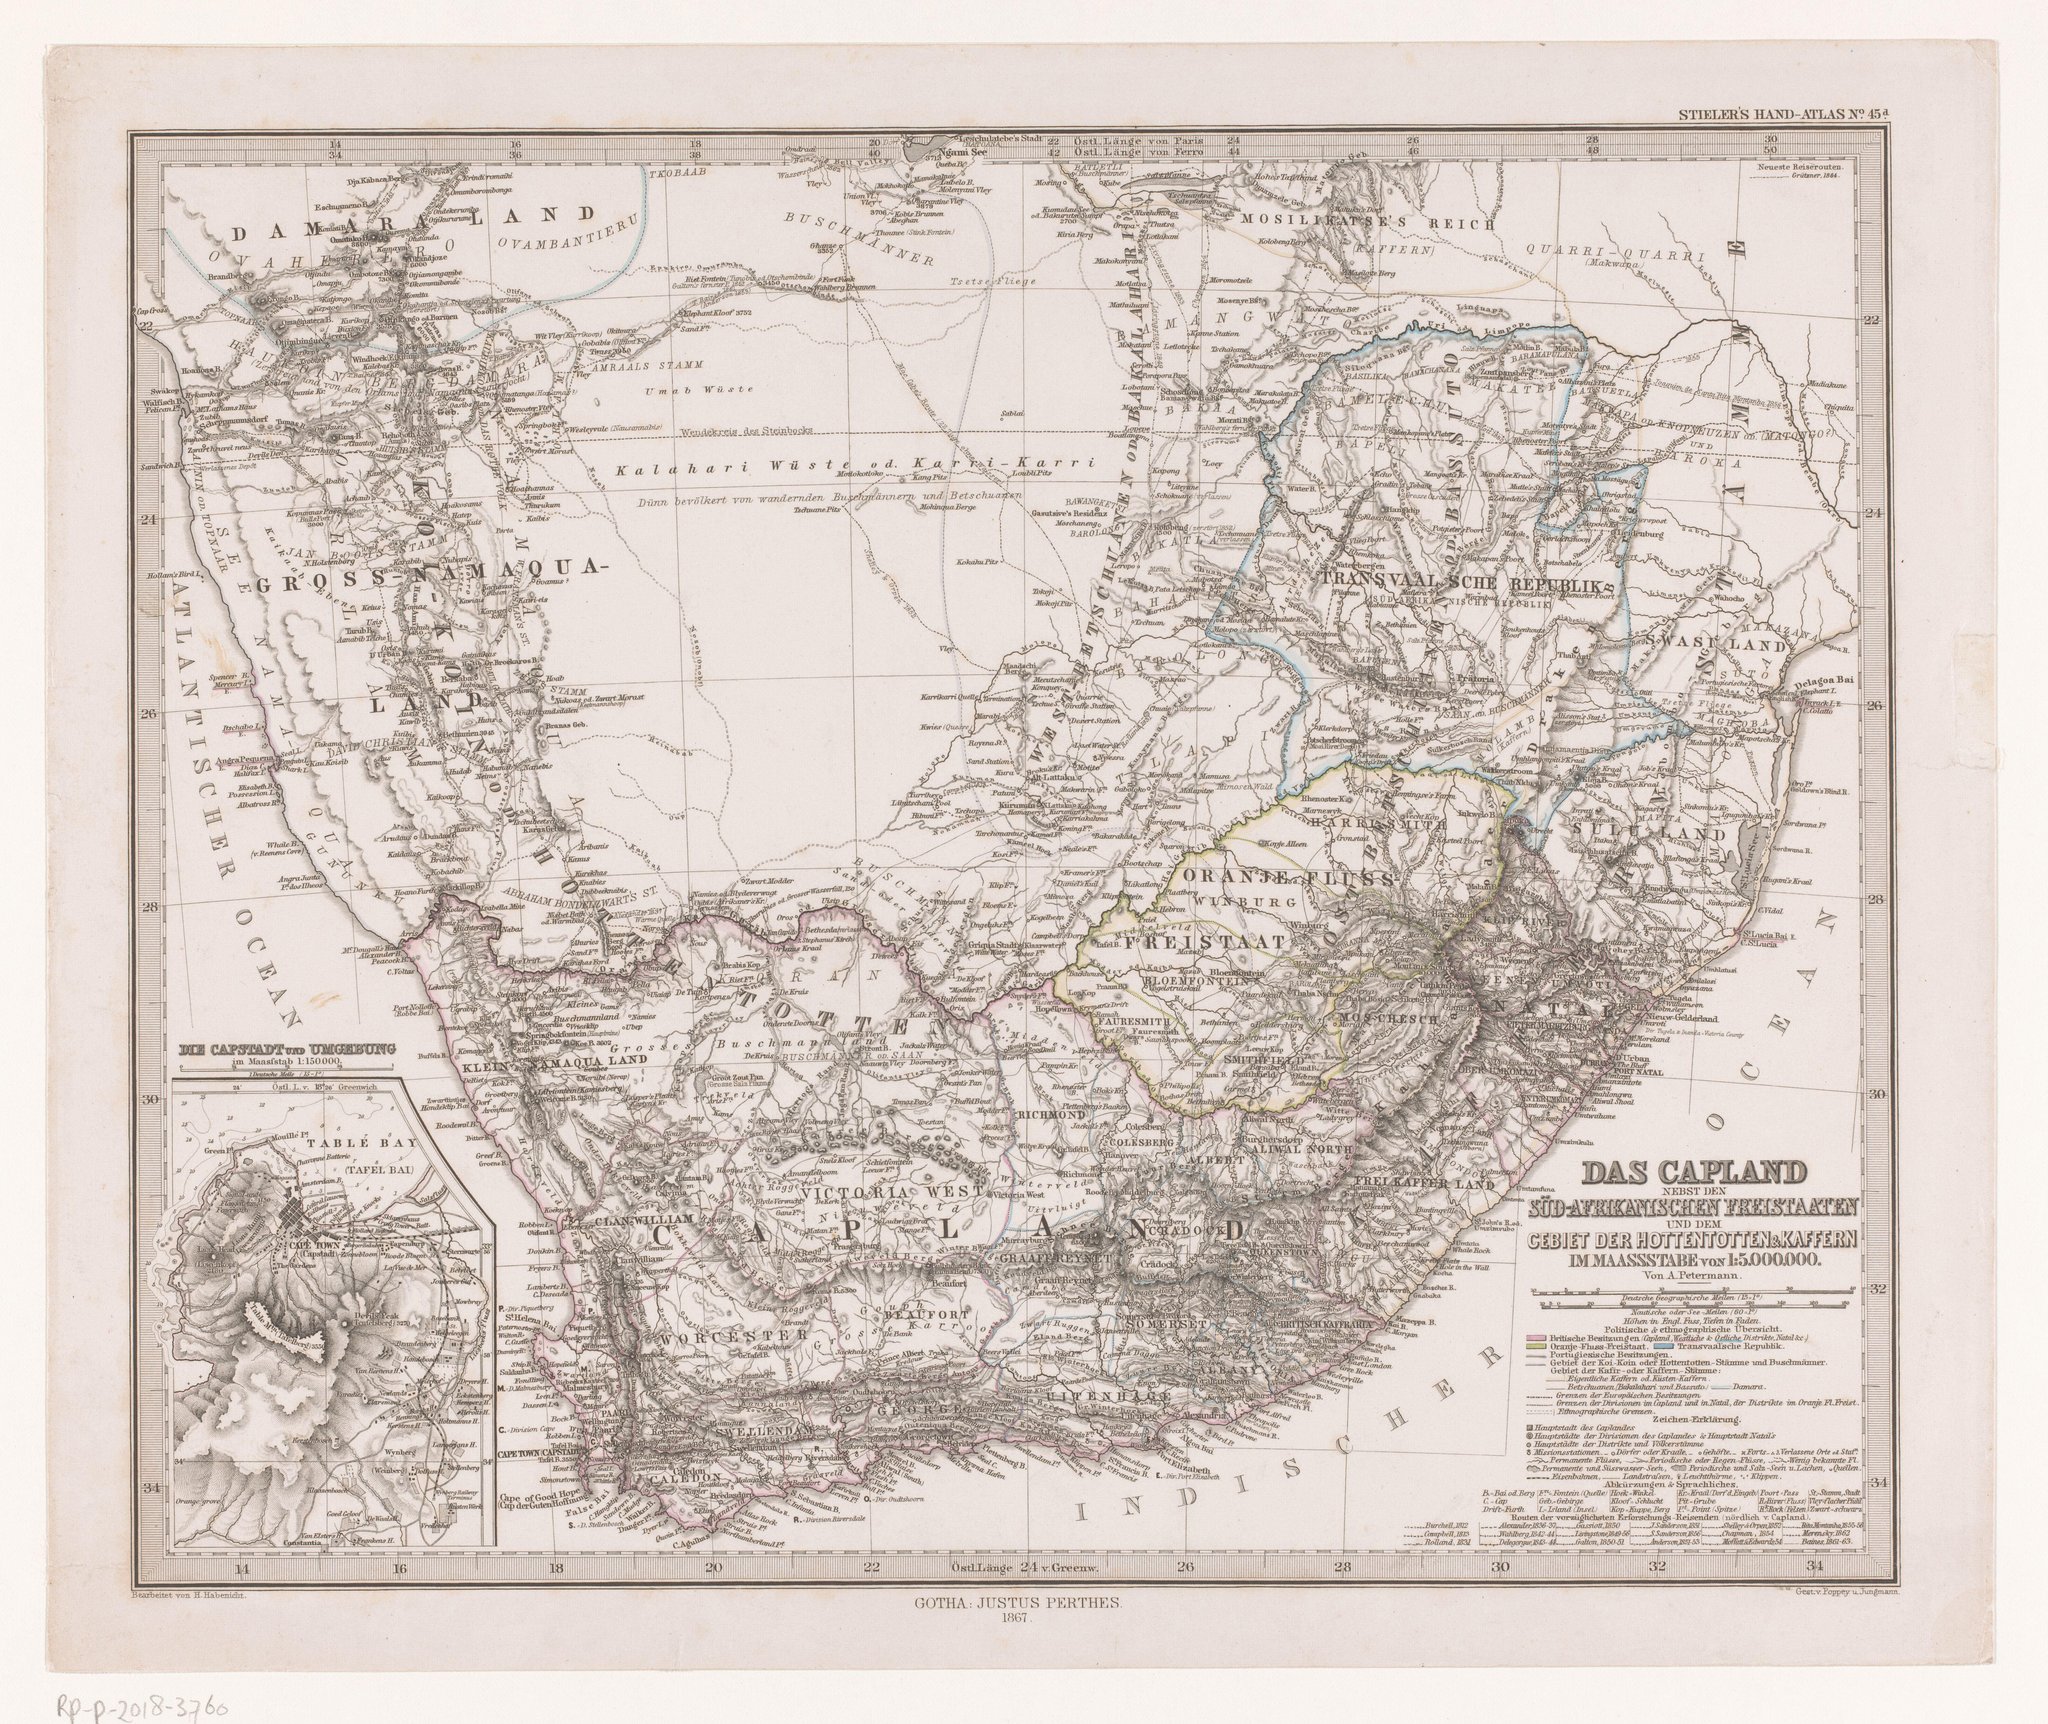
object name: map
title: Das Capland nebst den Süd-Afrikanischen Freistaaten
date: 1867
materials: paper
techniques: engraving, etching, hand coloring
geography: gotha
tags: (map of) africa, maps, atlases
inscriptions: date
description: Prent uit: Stülpnagel, Friedrich von. Stielers Handatlas. Gotha: Uitgeverij Justus Perthes, 1867, dl. 5.